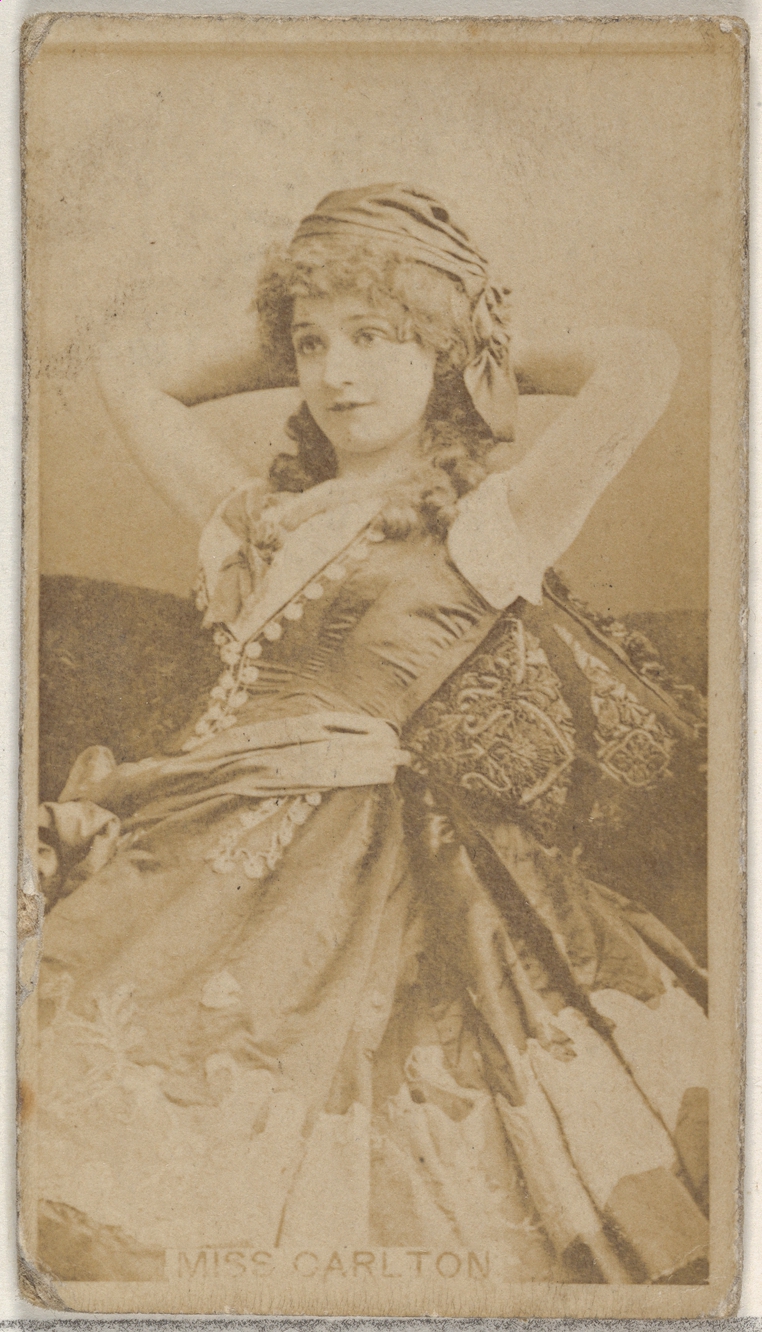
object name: photograph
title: Miss Carlton, from the Actors and Actresses series (N45, Type 8) for Virginia Brights Cigarettes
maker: allen & ginter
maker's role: publisher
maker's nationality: american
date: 1888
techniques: albumen silver print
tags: portraits,women,actresses